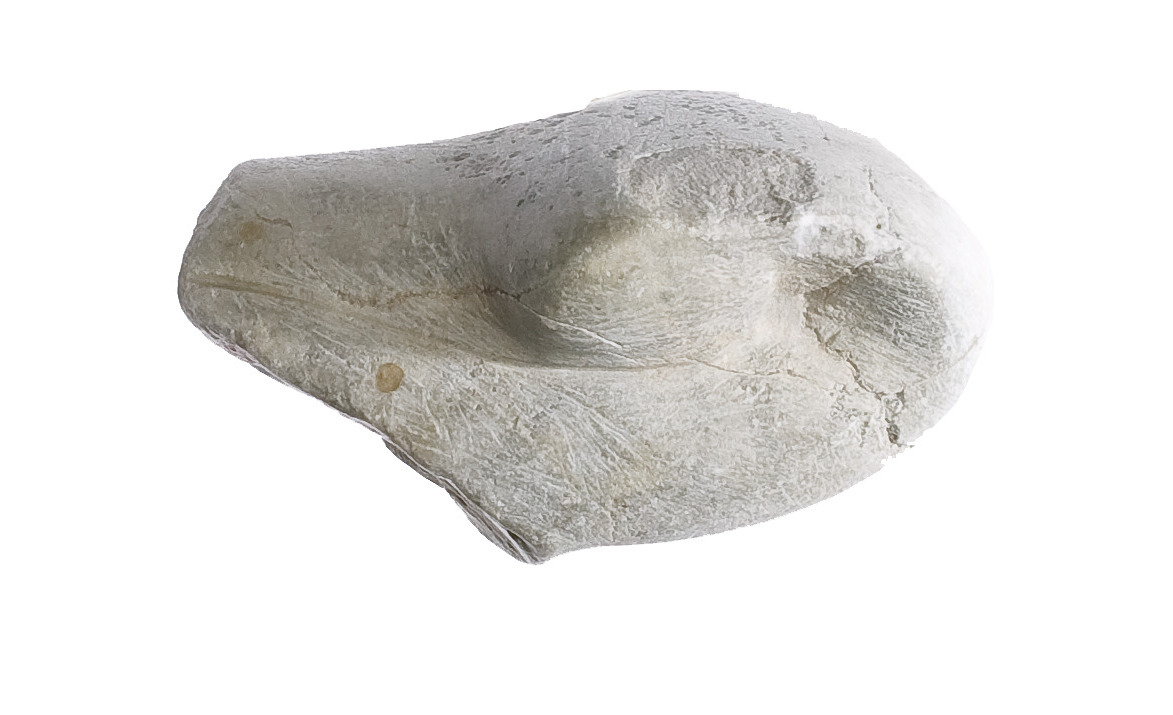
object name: cobra, head, uraeus, architectural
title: Cobra head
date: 1353-1336 BCE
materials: limestone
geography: egypt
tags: snakes